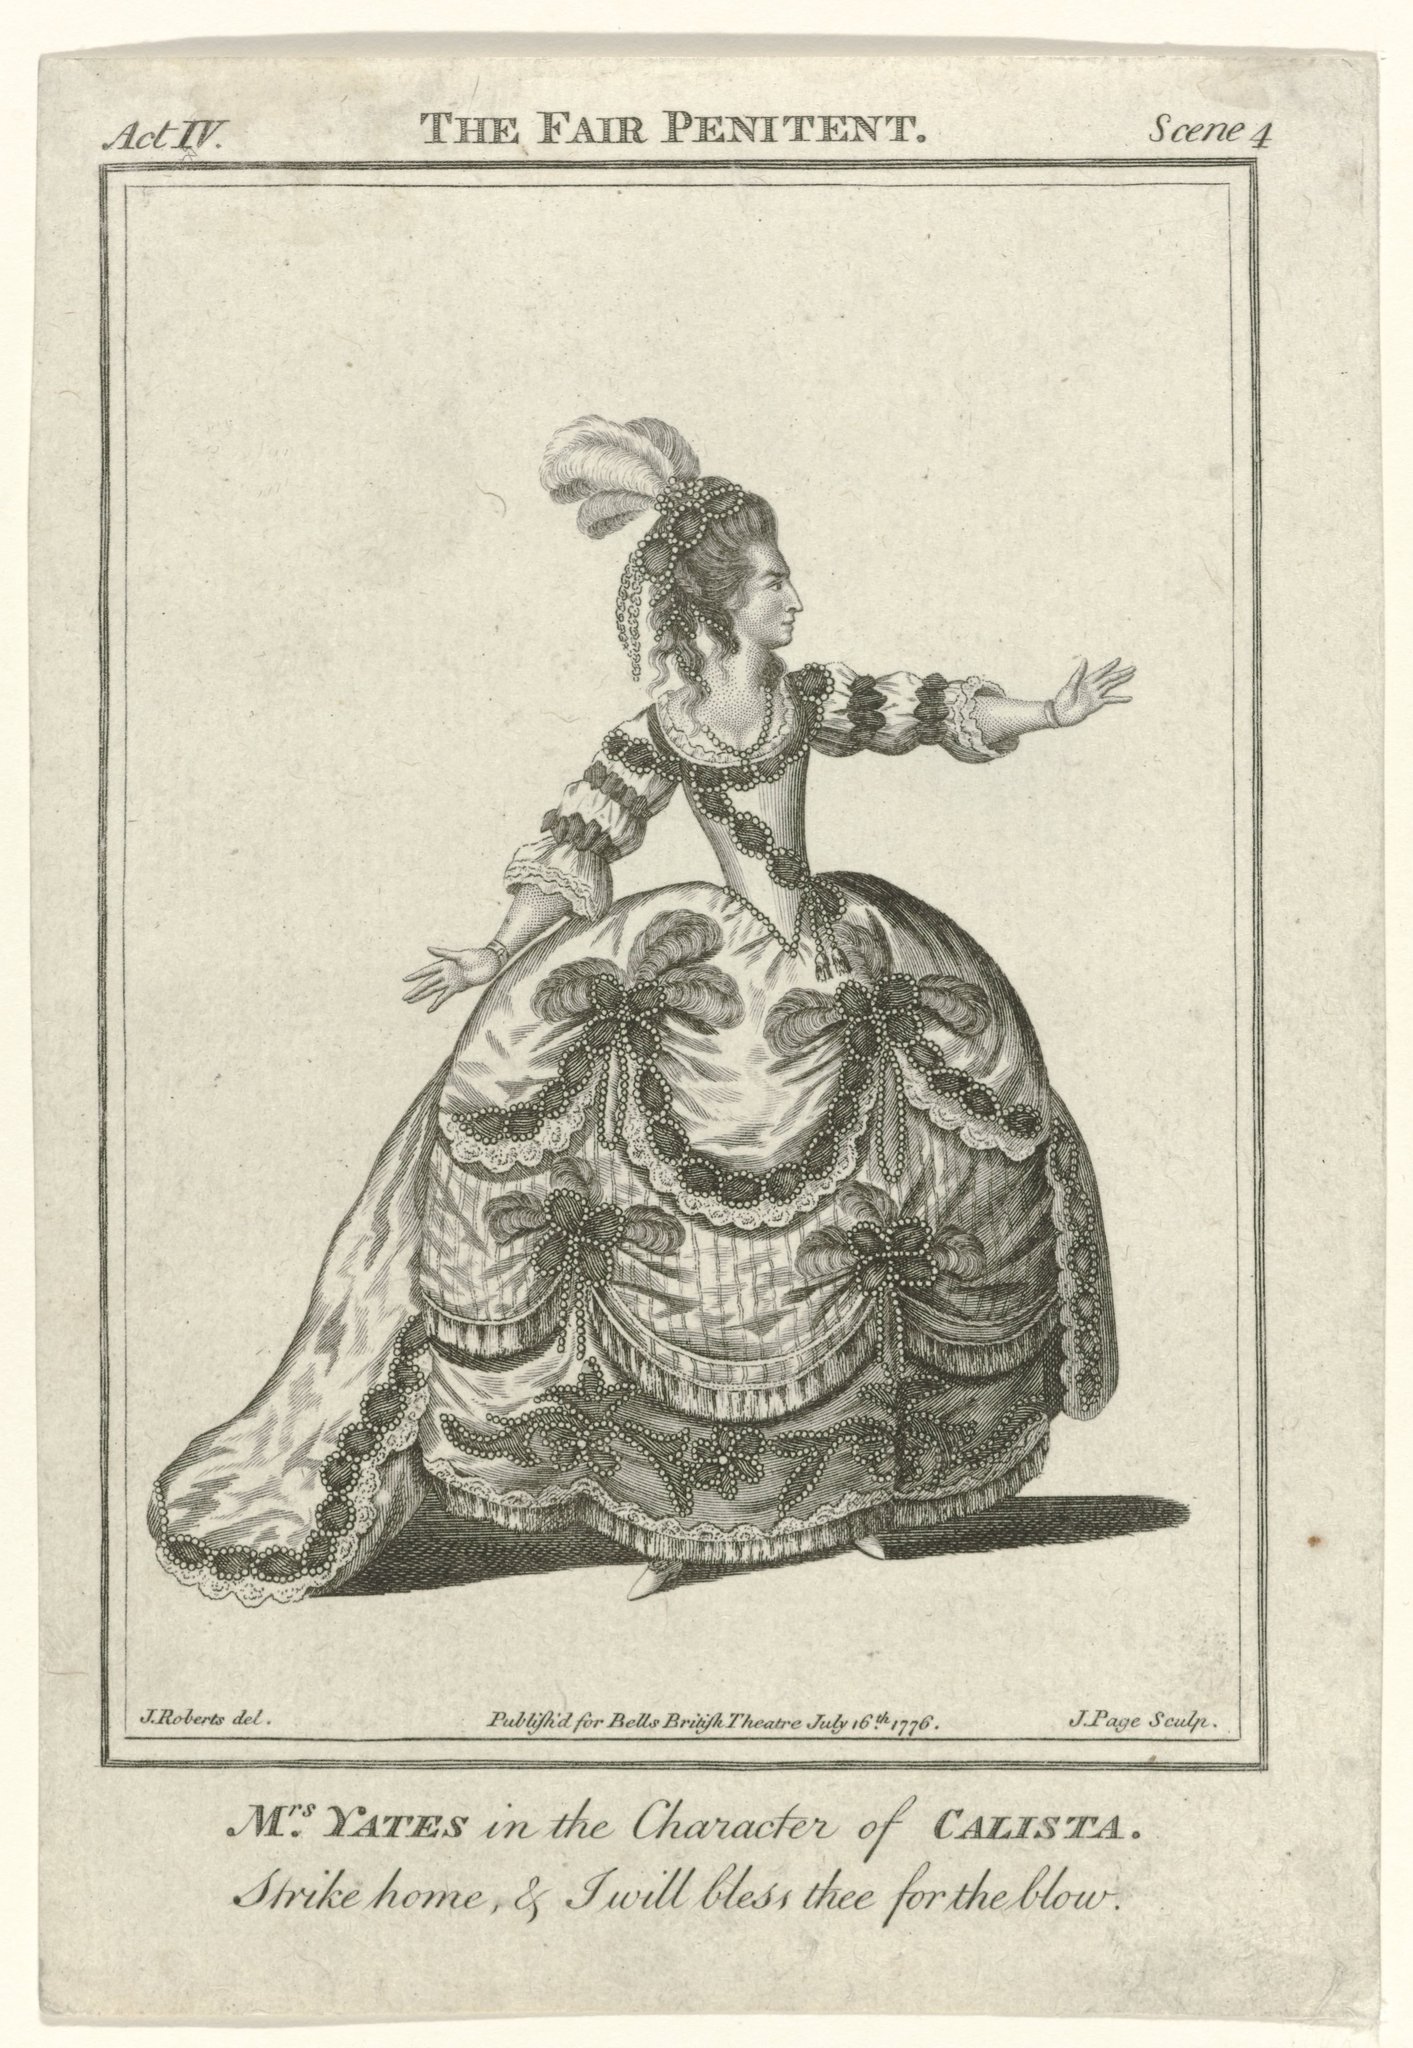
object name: costume print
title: The Fair Penitent.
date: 1776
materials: paper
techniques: engraving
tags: styles of hairdress - aa - ~ women, fashion plates, dress, gown (+ women's clothes), actress (on the stage)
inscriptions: inscription: ‘Published for Bells British theatre July 16th.1776.’, title: ‘Act IV. The Fair Penitent. Scene 4.’, caption: ‘Mrs. Yates in the character of Calista. Strike home & I will bless thee for the blow.’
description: Portret van actrice Mrs. Mary Ann Yates (1728–1787) in de rol van Calista tijdens Act IV, Scene 4. Zij draagt een rijkelijk versierde japon met sleep. De rok bestaat uit drie lagen, elk versierd met veren en gedecoreerd band. Het haar is opgekapt en versierd met veren. Om beide polsen armbanden. De prent is uitgegeven voor het Bells British Theatre op 16 juli 1776.